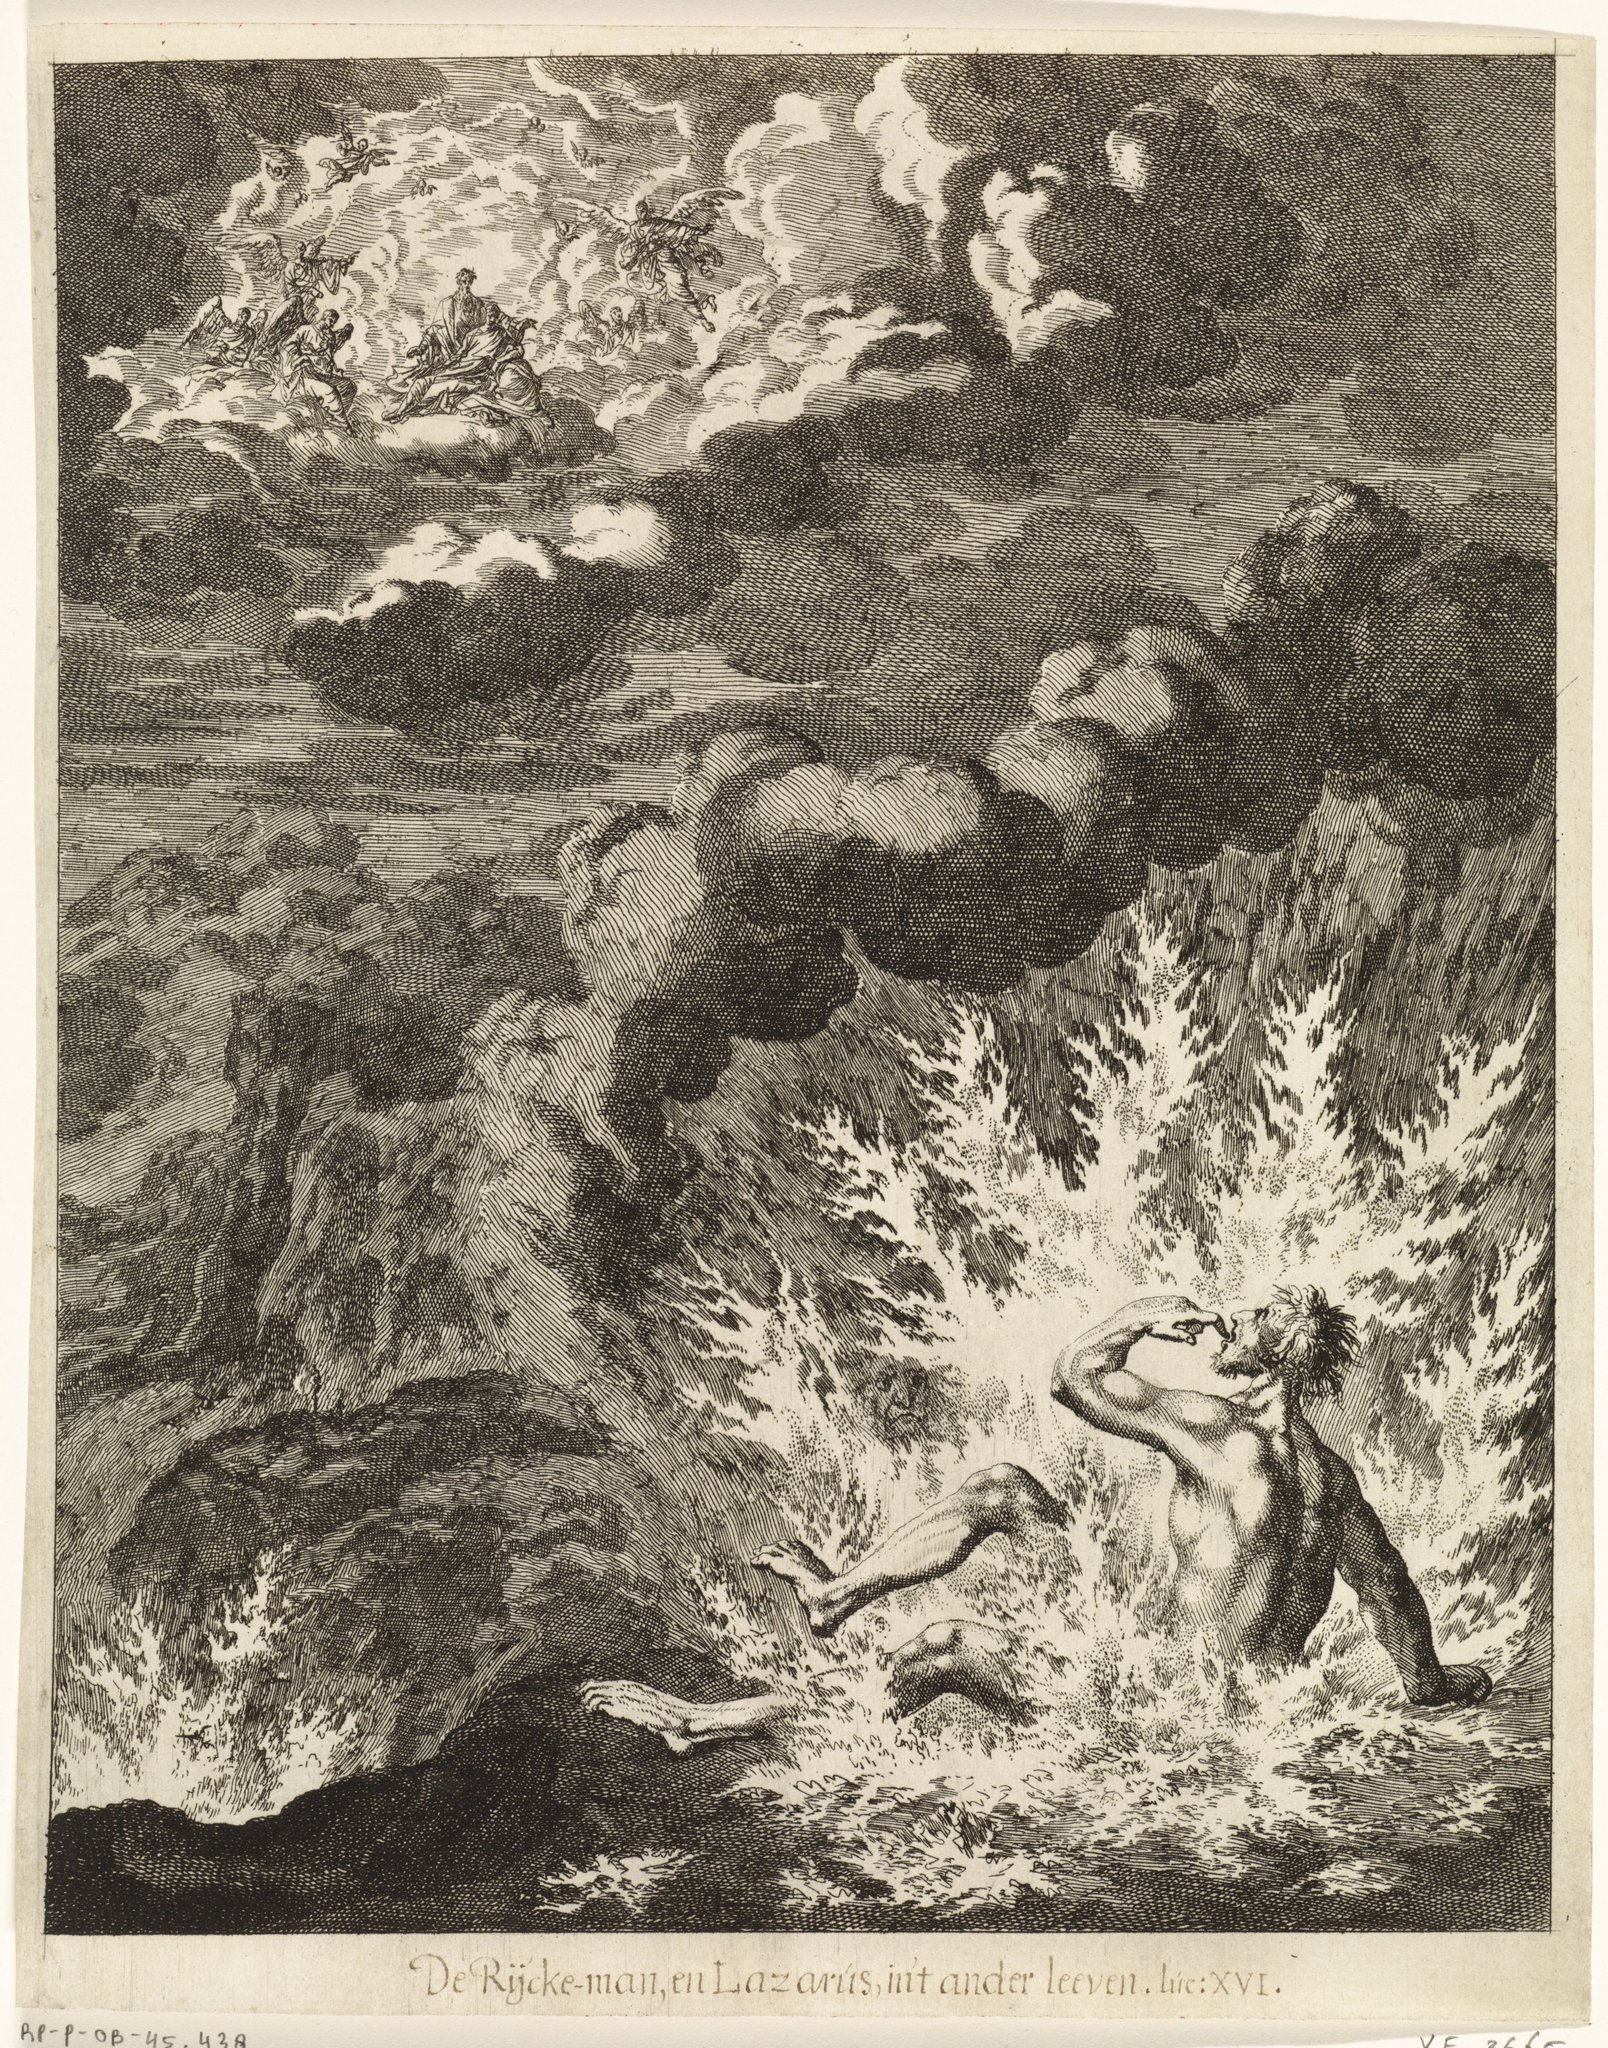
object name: print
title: Rijke man in de hel en Lazarus in de hemel bij Abraham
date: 1708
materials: paper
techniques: etching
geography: amsterdam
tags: the rich man (dives) is feasting, while poor lazarus is starving at the gate (dogs licking lazarus' sores) (luke 16:19-31)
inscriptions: collector's mark: Lugt 2228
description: Proefdruk van een prent welke is opgenomen als illustratie in: Historiae Celebriores Veteris Testamenti. Christoph Weigel, 1708.